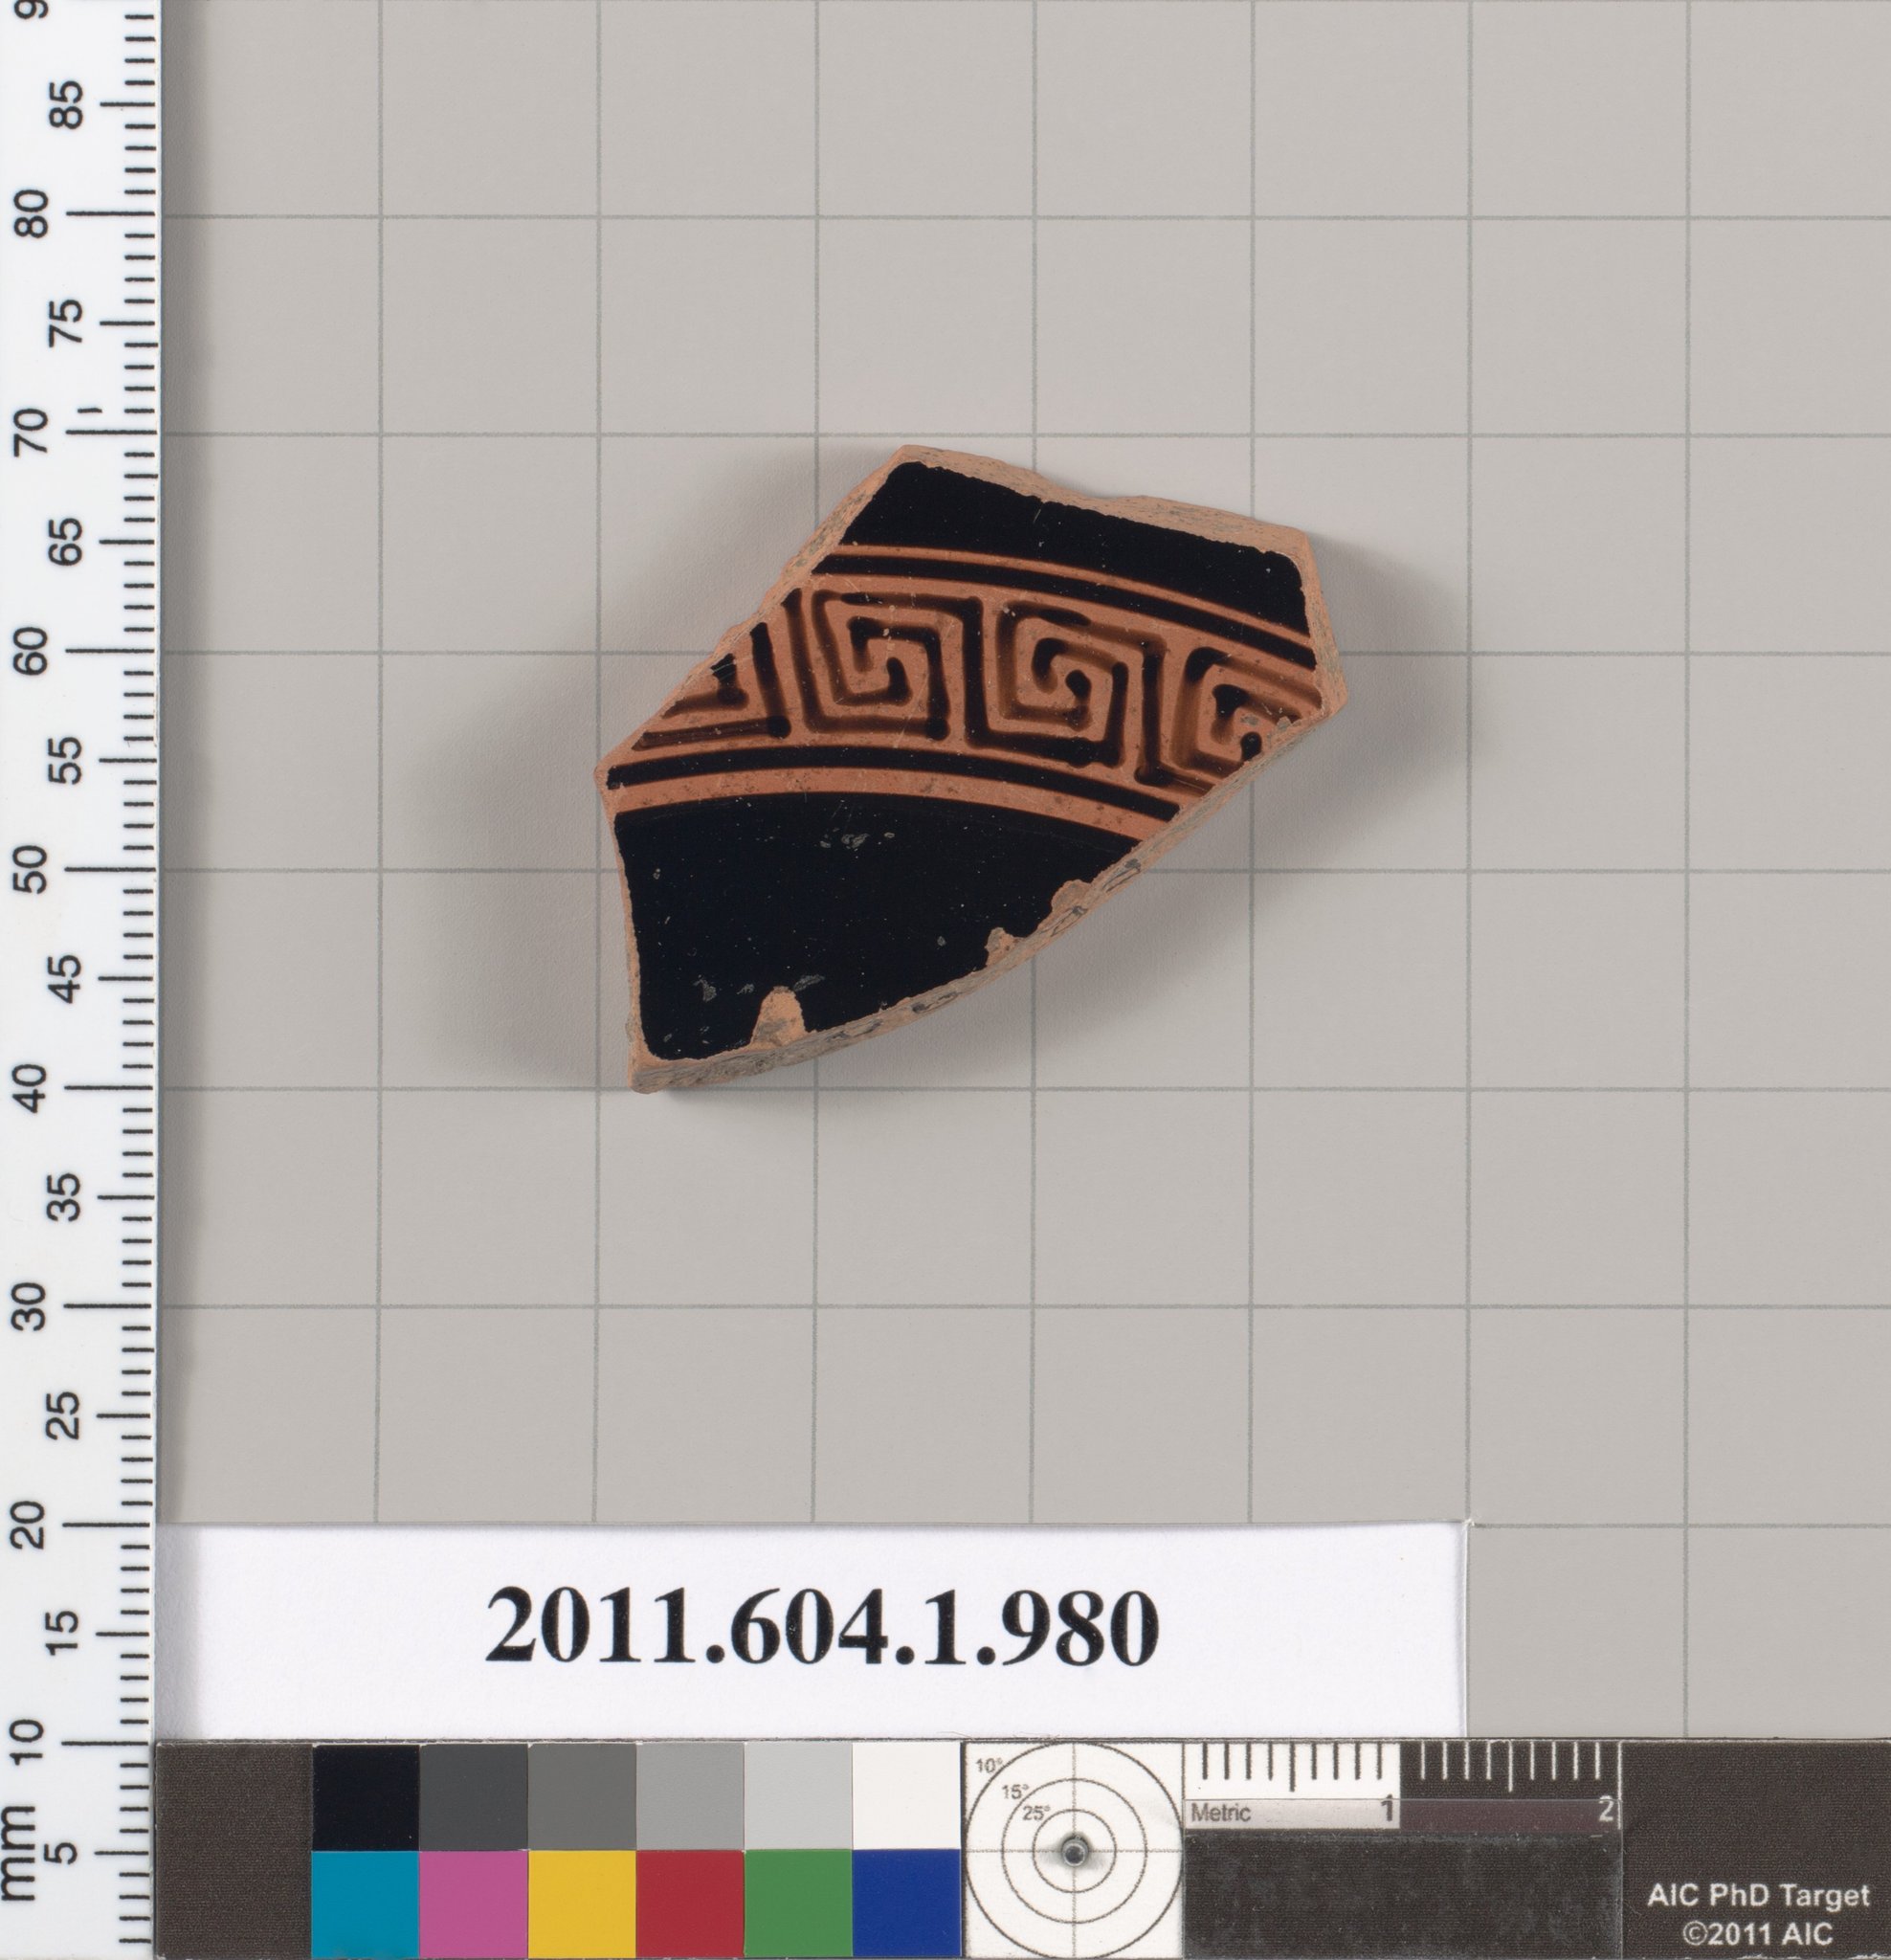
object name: kylix fragment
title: Terracotta fragment of a kylix (drinking cup)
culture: greek, attic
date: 490-480 BCE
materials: terracotta